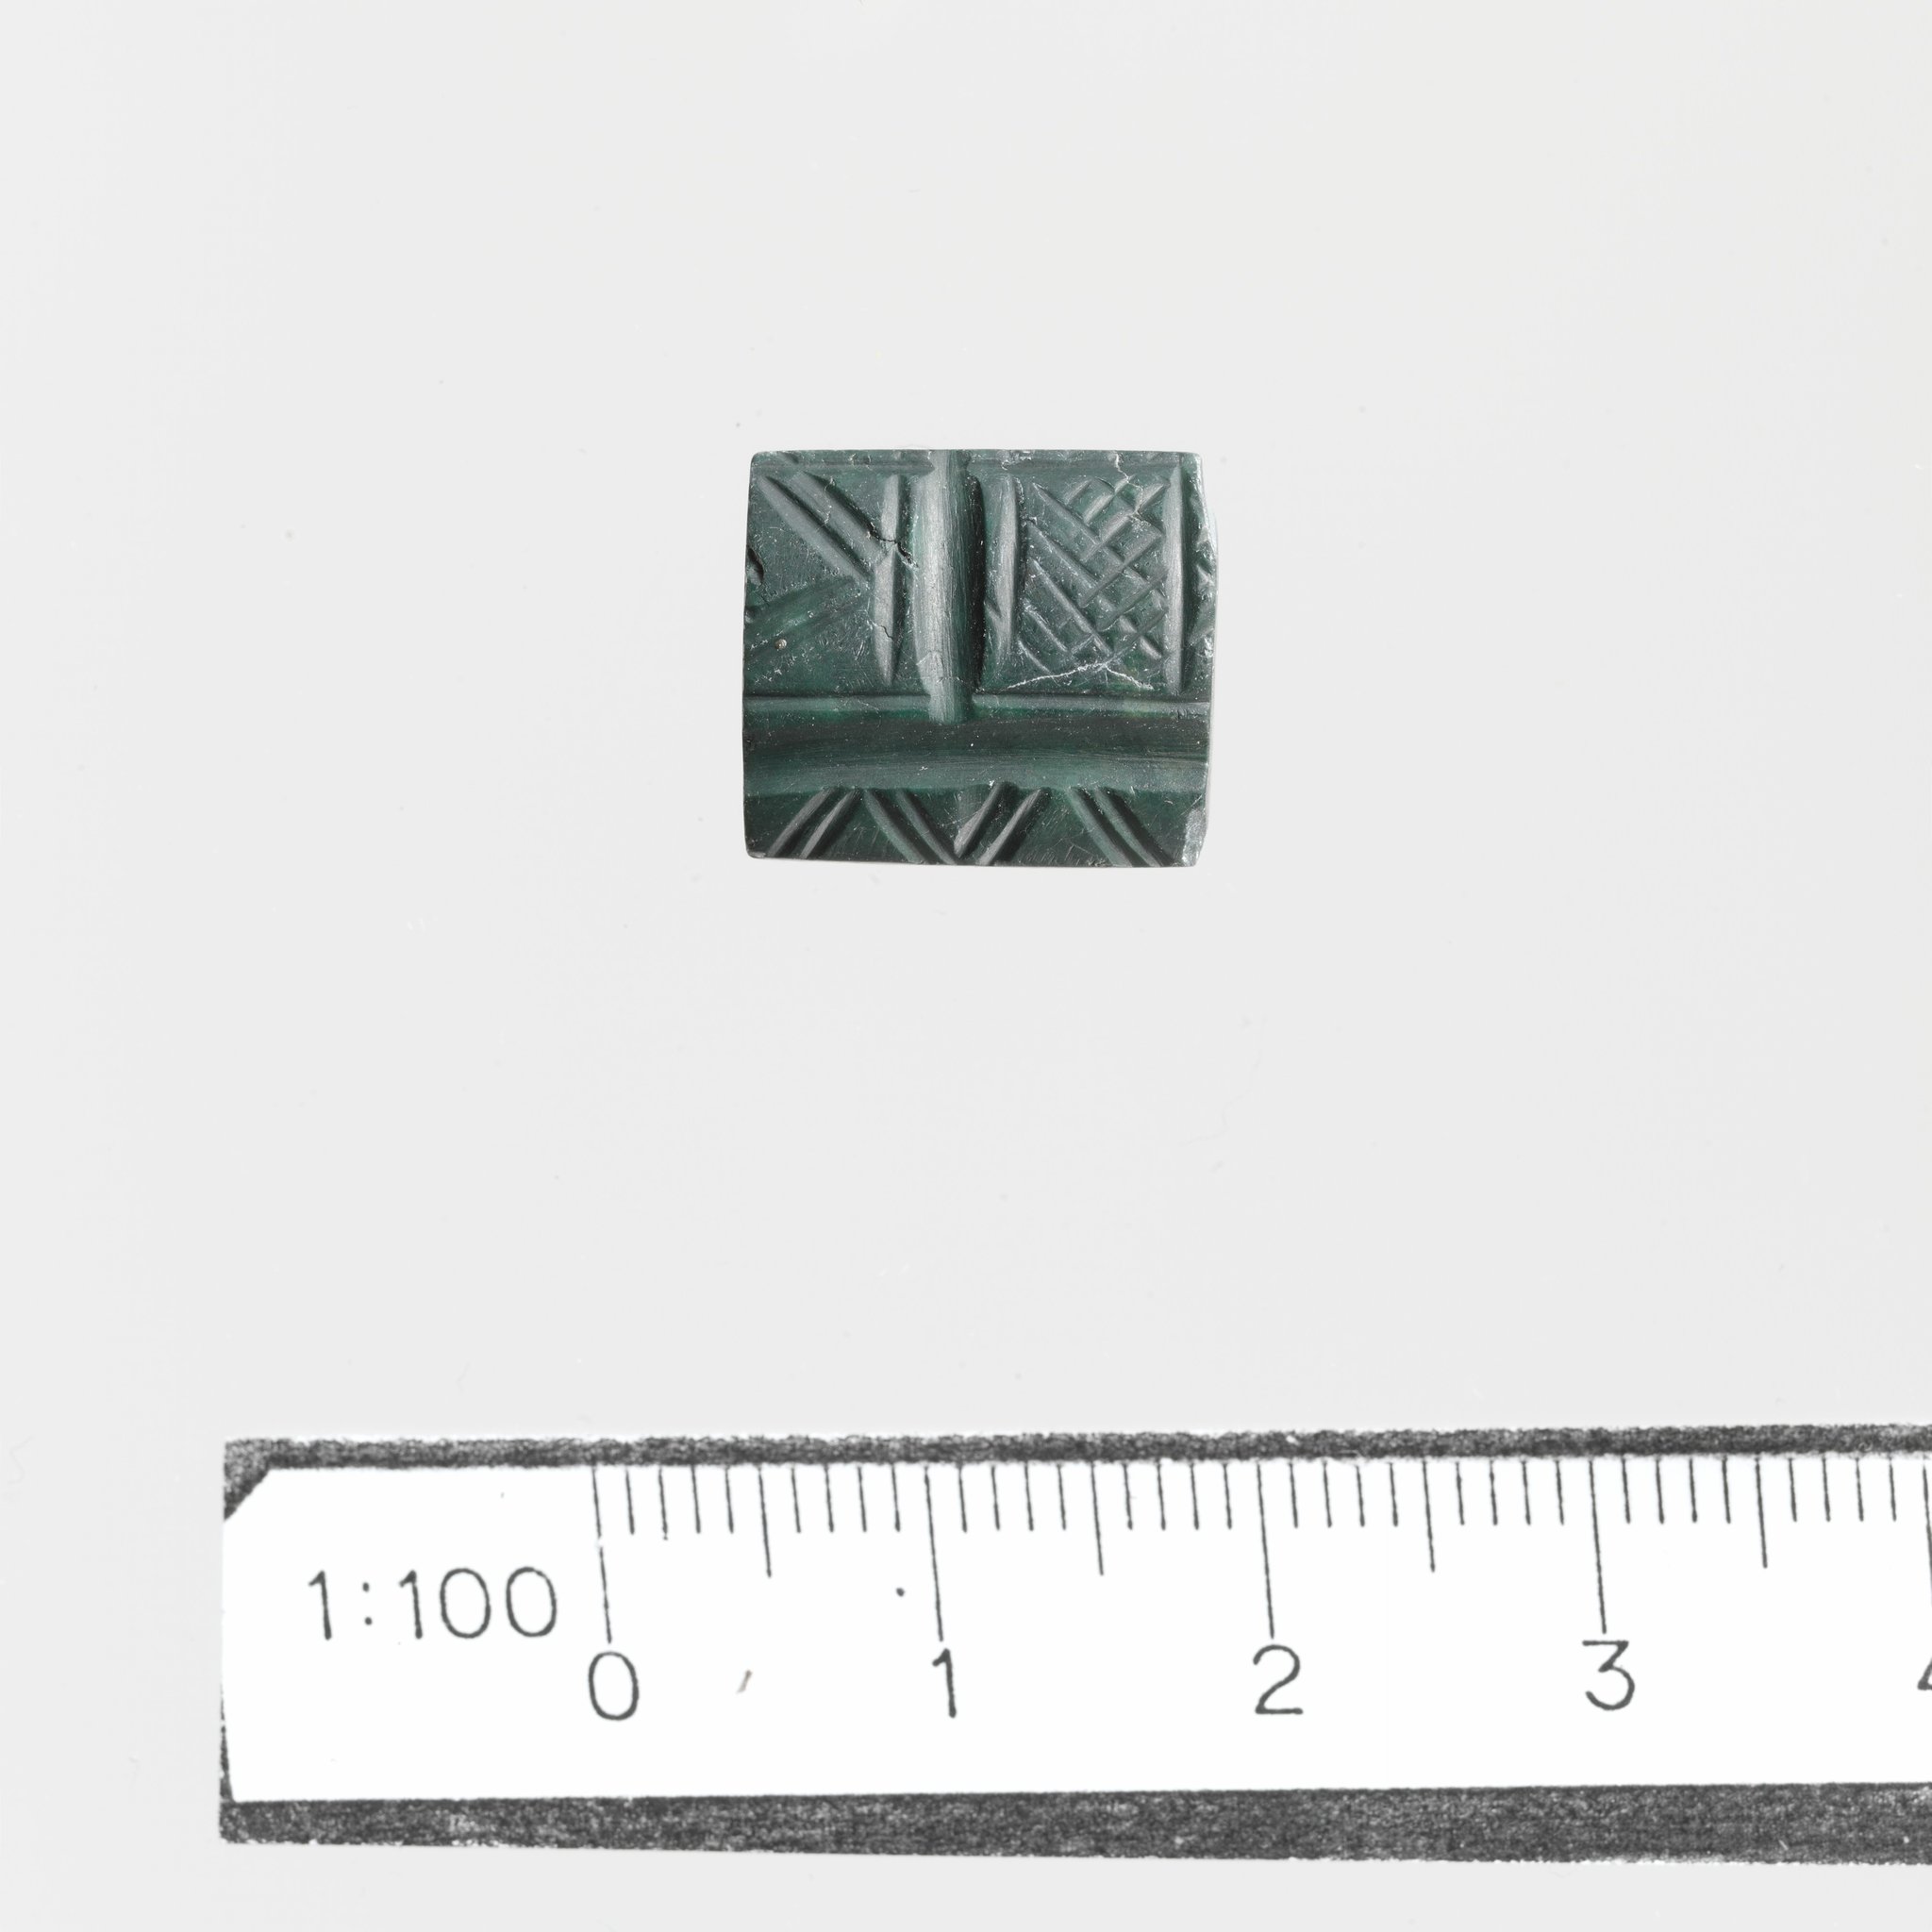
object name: seal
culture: minoan, crete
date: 2000-1450 BCE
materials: glass